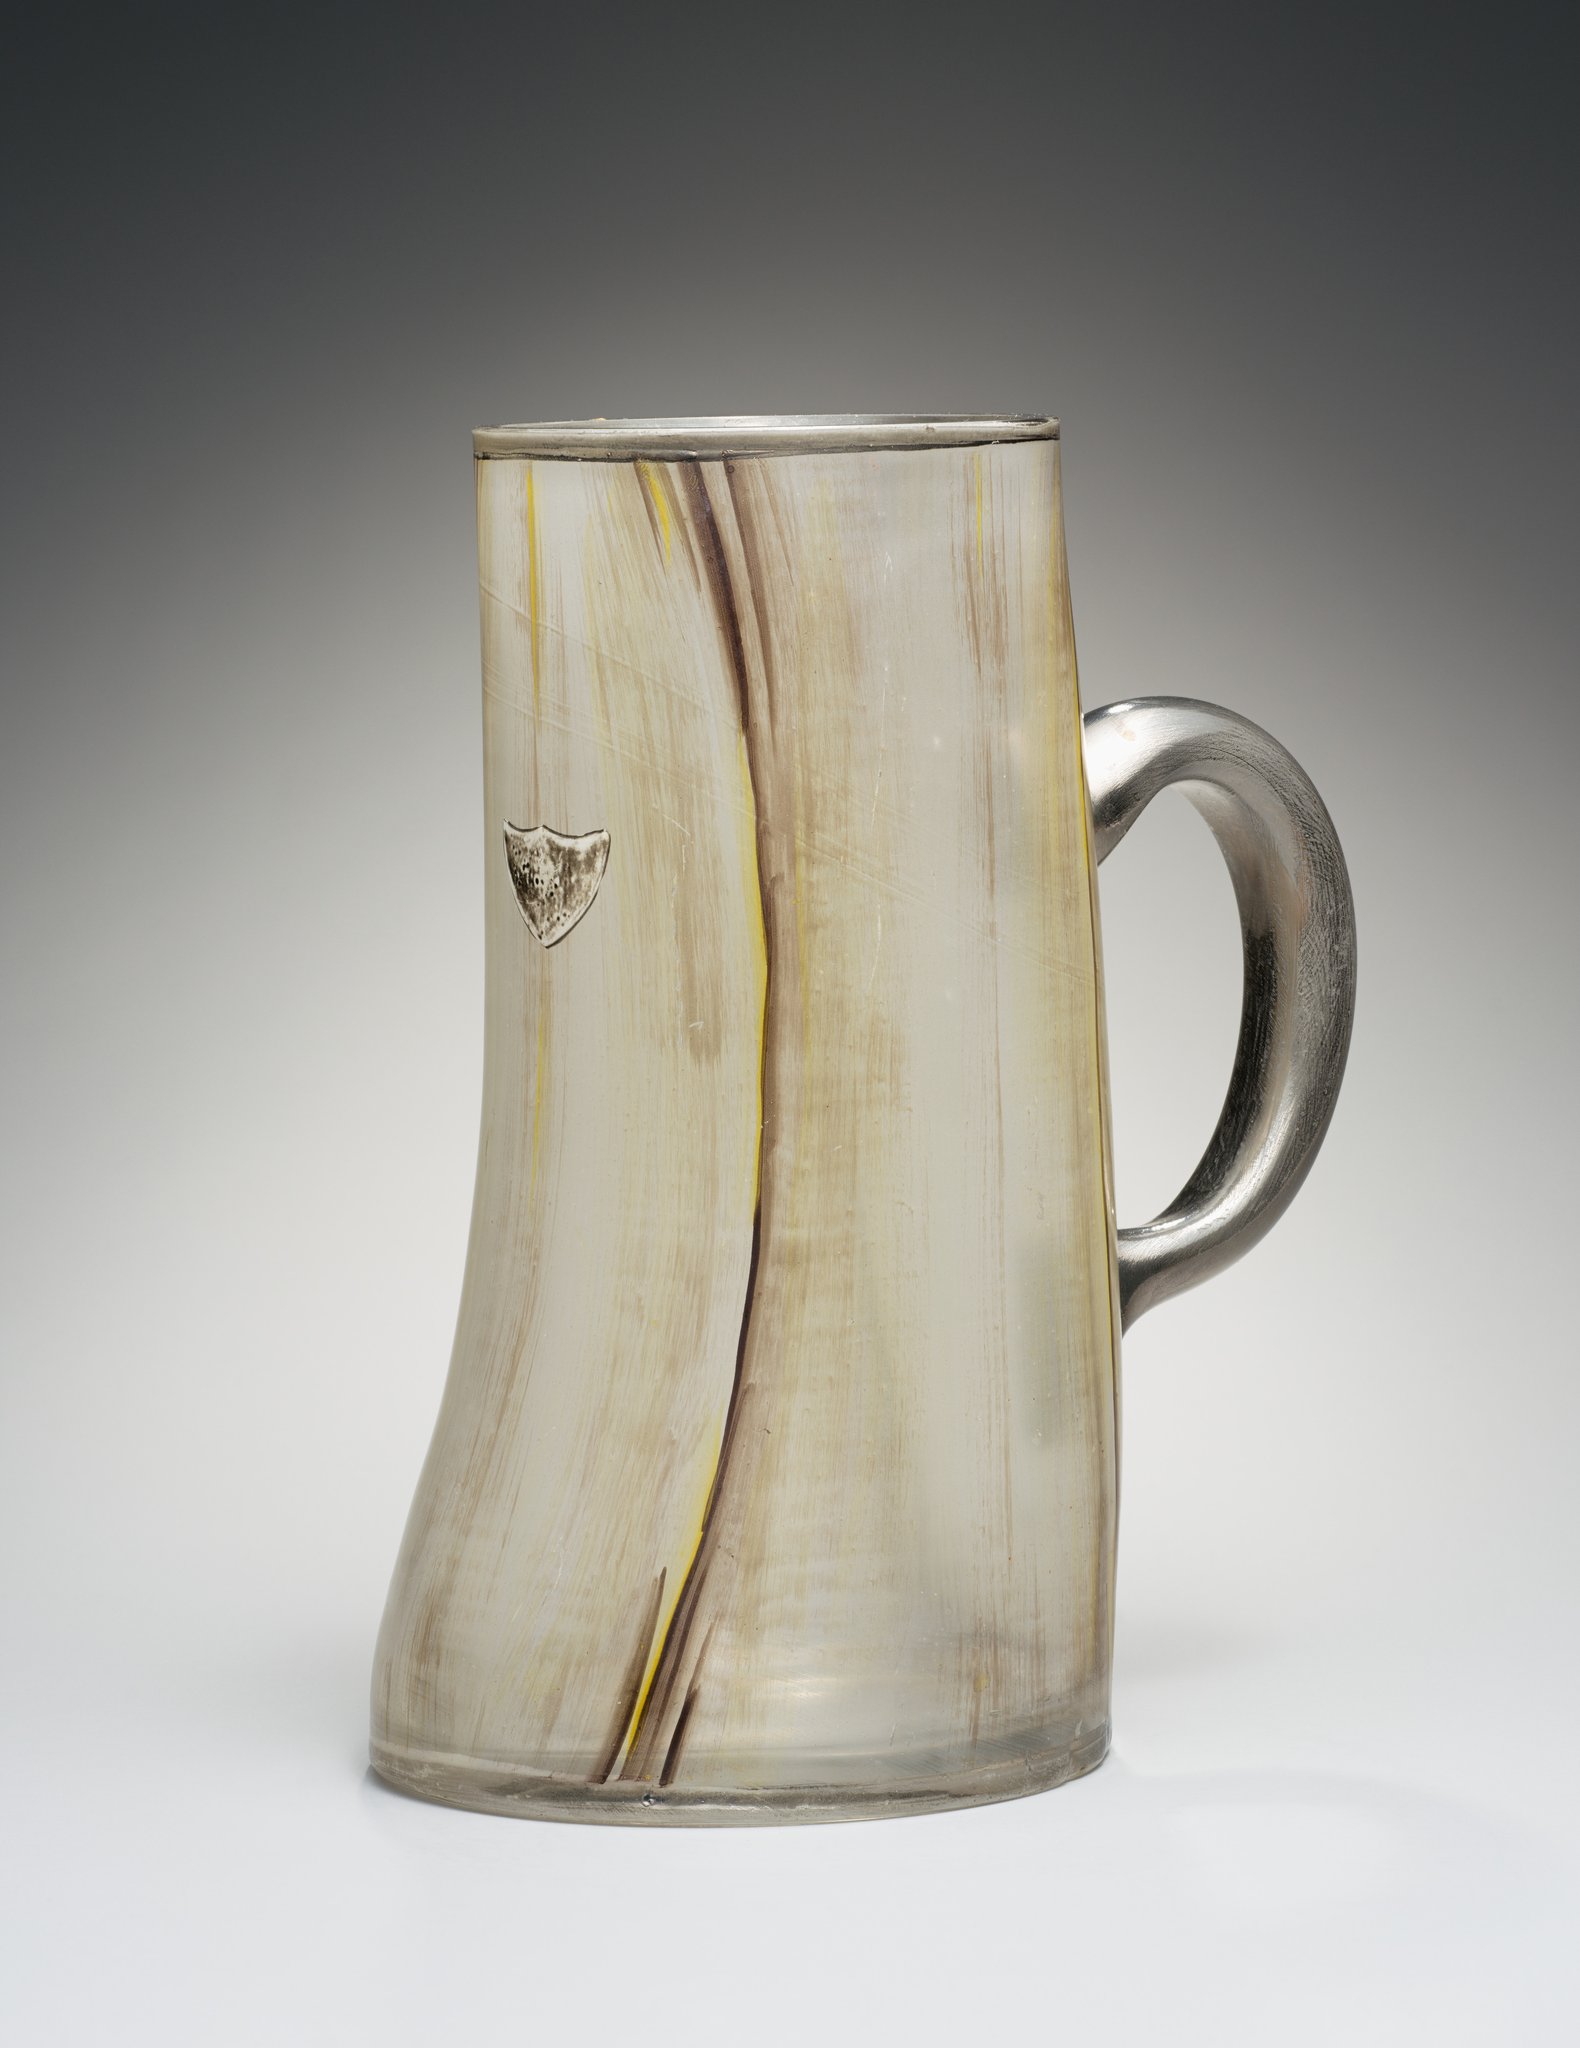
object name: mug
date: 1834-1866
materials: glass